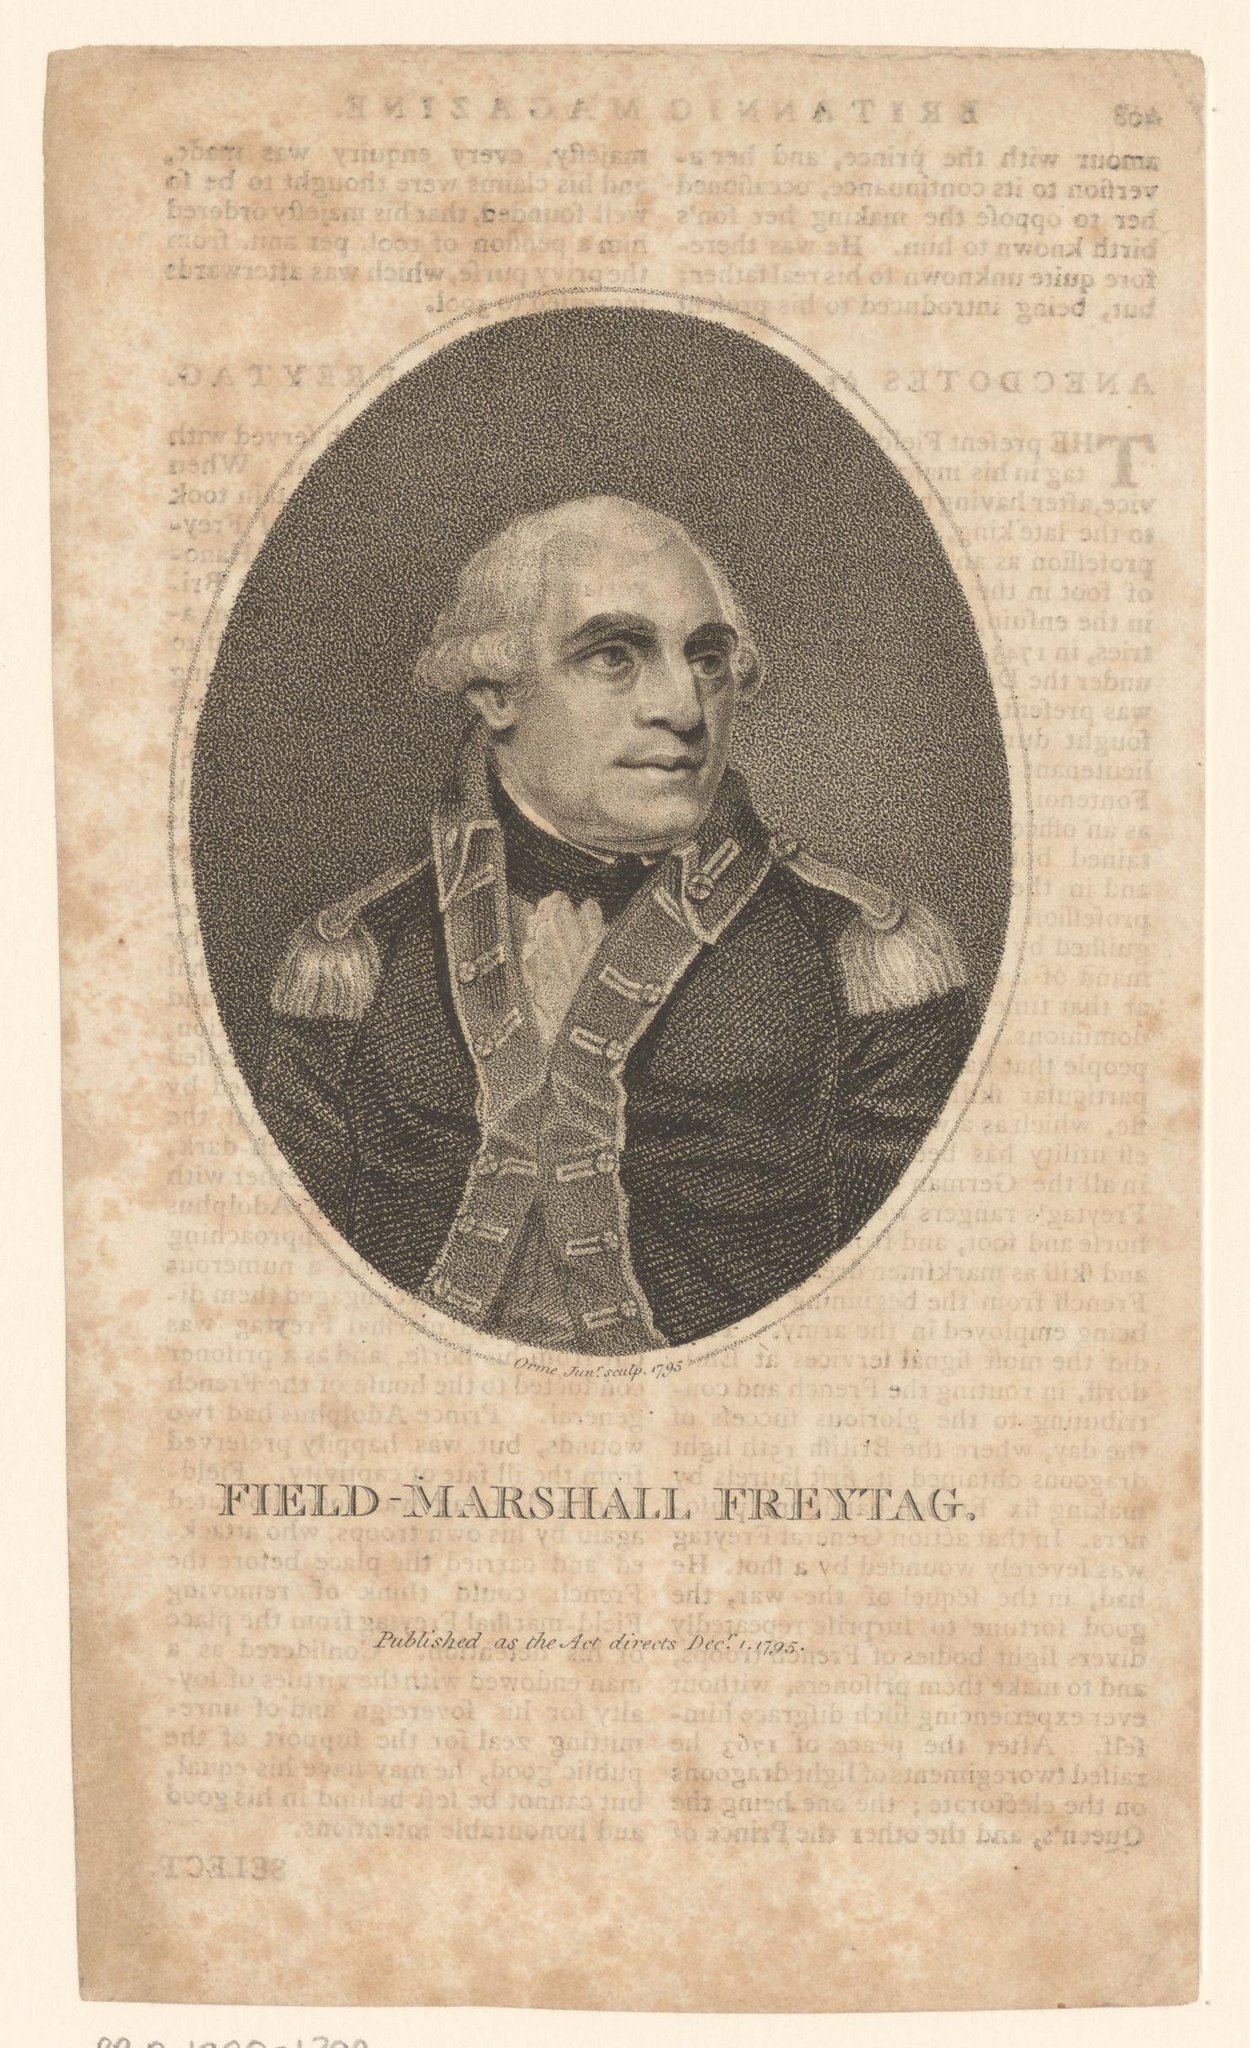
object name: print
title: Portret van Wilhelm von Freytag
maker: daniel orme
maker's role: print maker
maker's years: 1766-1802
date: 1795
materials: paper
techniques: engraving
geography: london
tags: historical persons, officer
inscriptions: collector's mark: Lugt 2228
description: Prent ook gebruikt in: The Britannic Magazine (...). Londen: s.n., 1795, dl. 3.